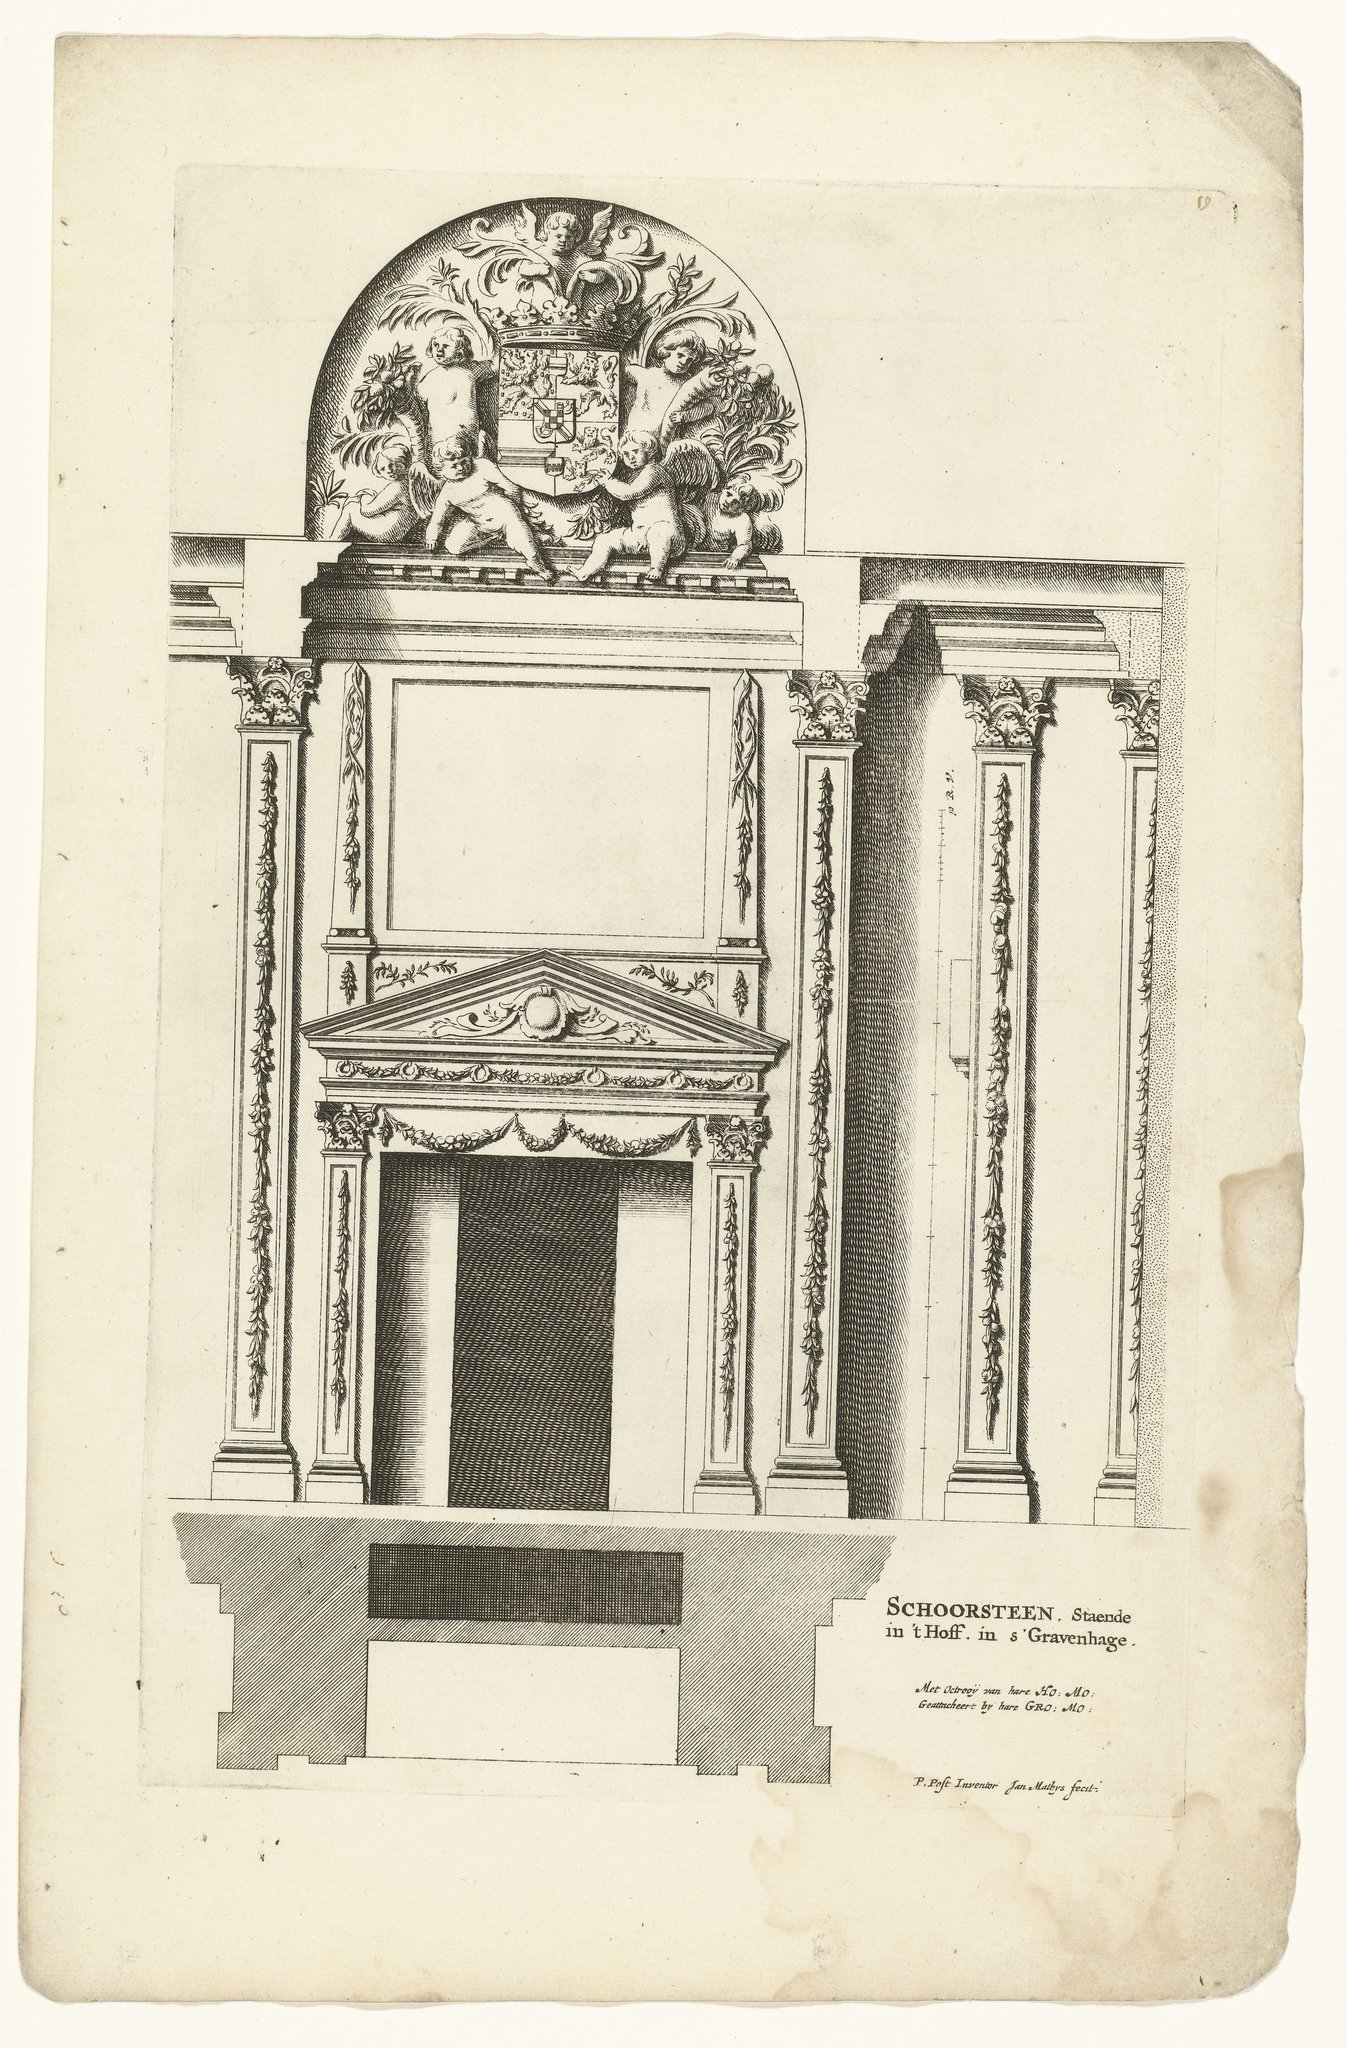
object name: ornament print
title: Onderboezem in Paleis Noordeinde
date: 1664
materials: paper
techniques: engraving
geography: the hague